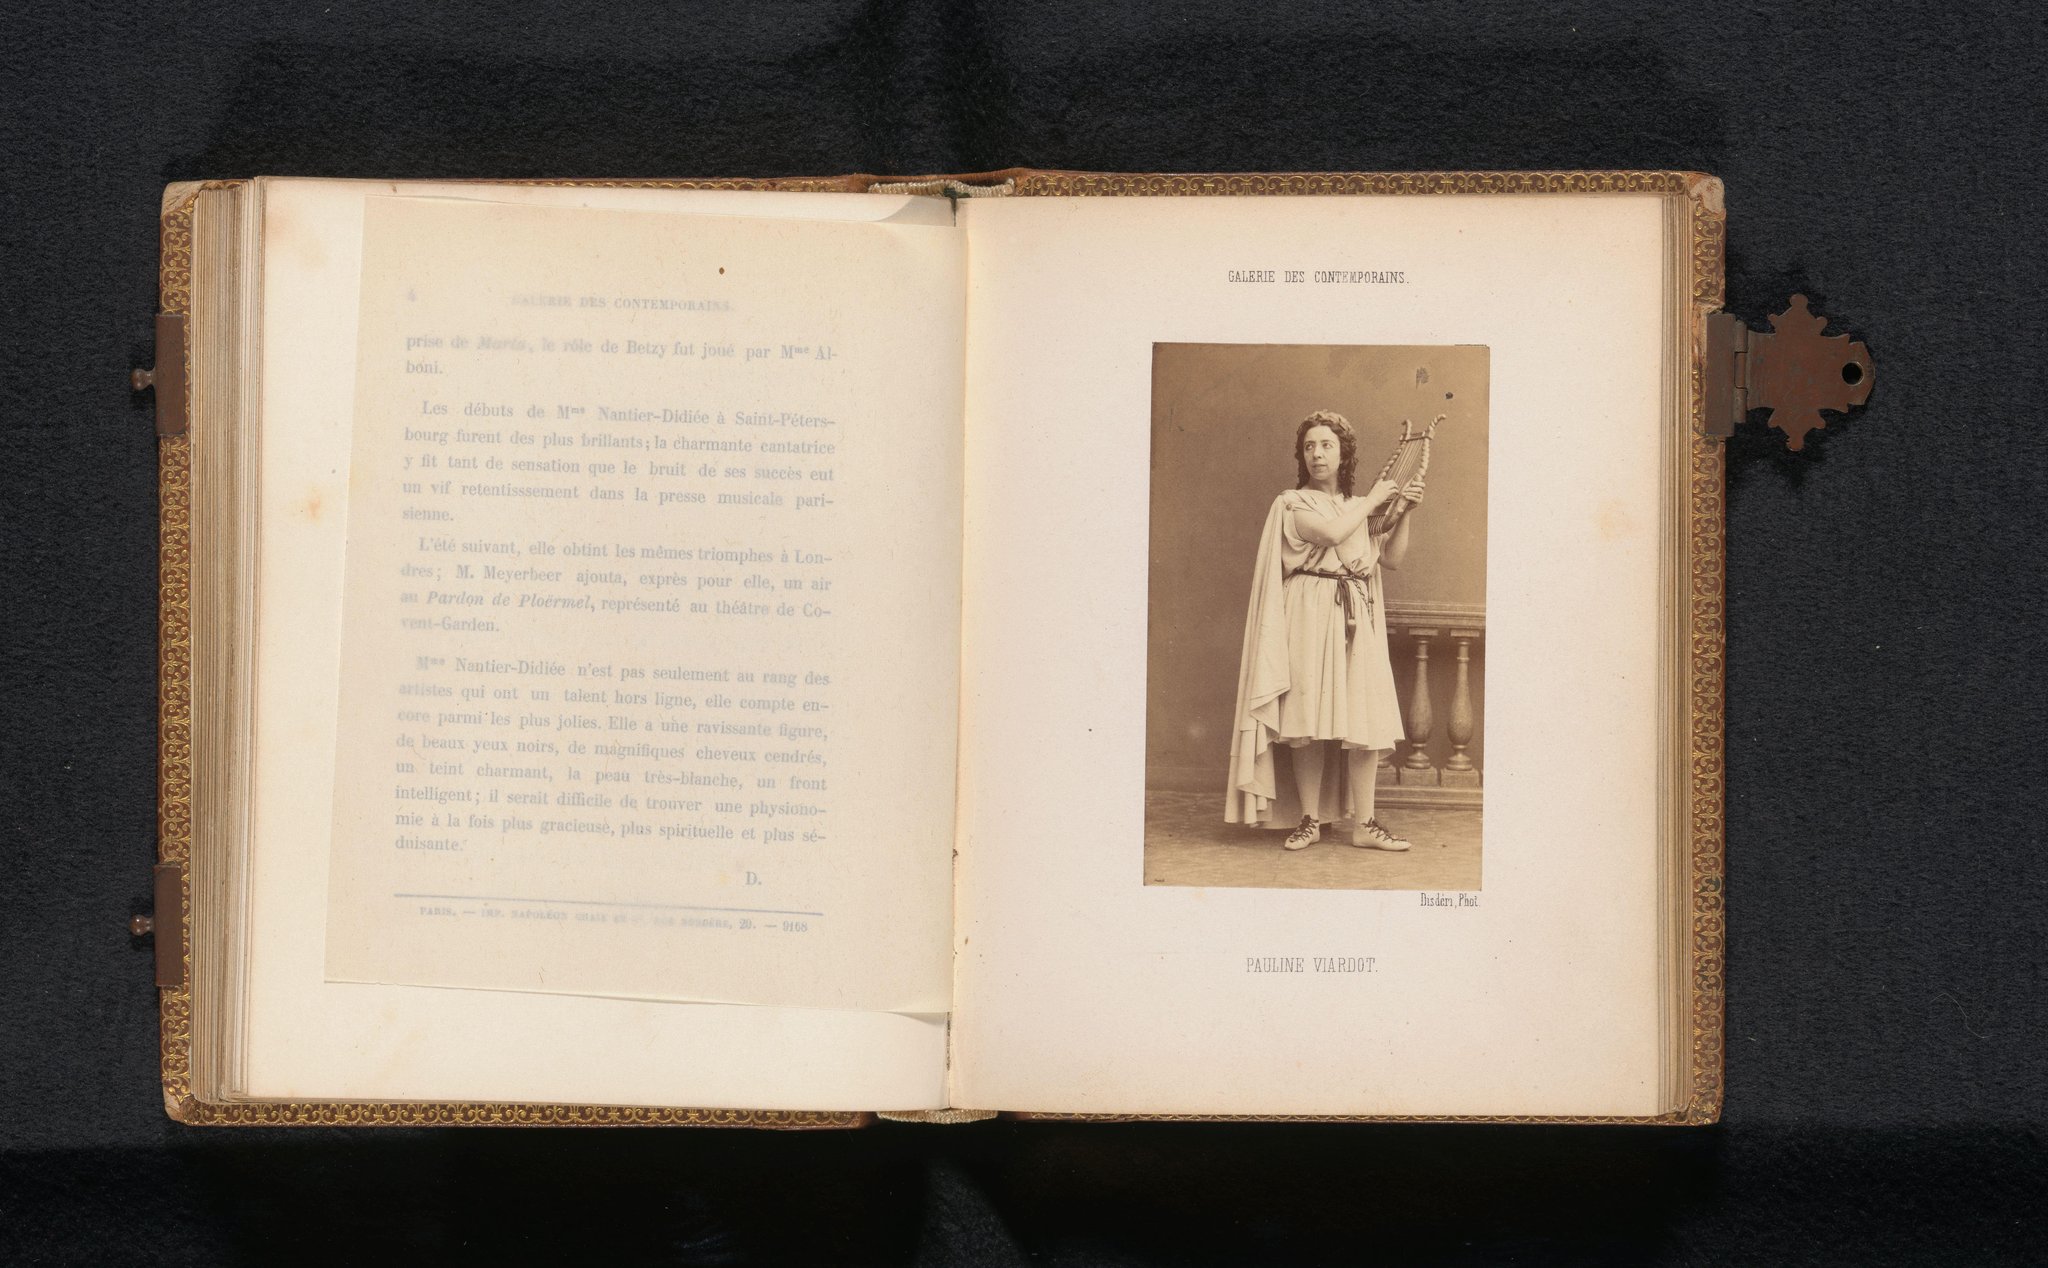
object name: page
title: Portret van Pauline Viardot-García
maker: andré-adolphe-eugène disdéri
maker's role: fotograaf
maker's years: 1819-1889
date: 1857-1862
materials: photographic support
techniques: albumen print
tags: pauline viardot-garcia, adult woman, historical persons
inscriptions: inscription: ‘Galerie des Contemporains’